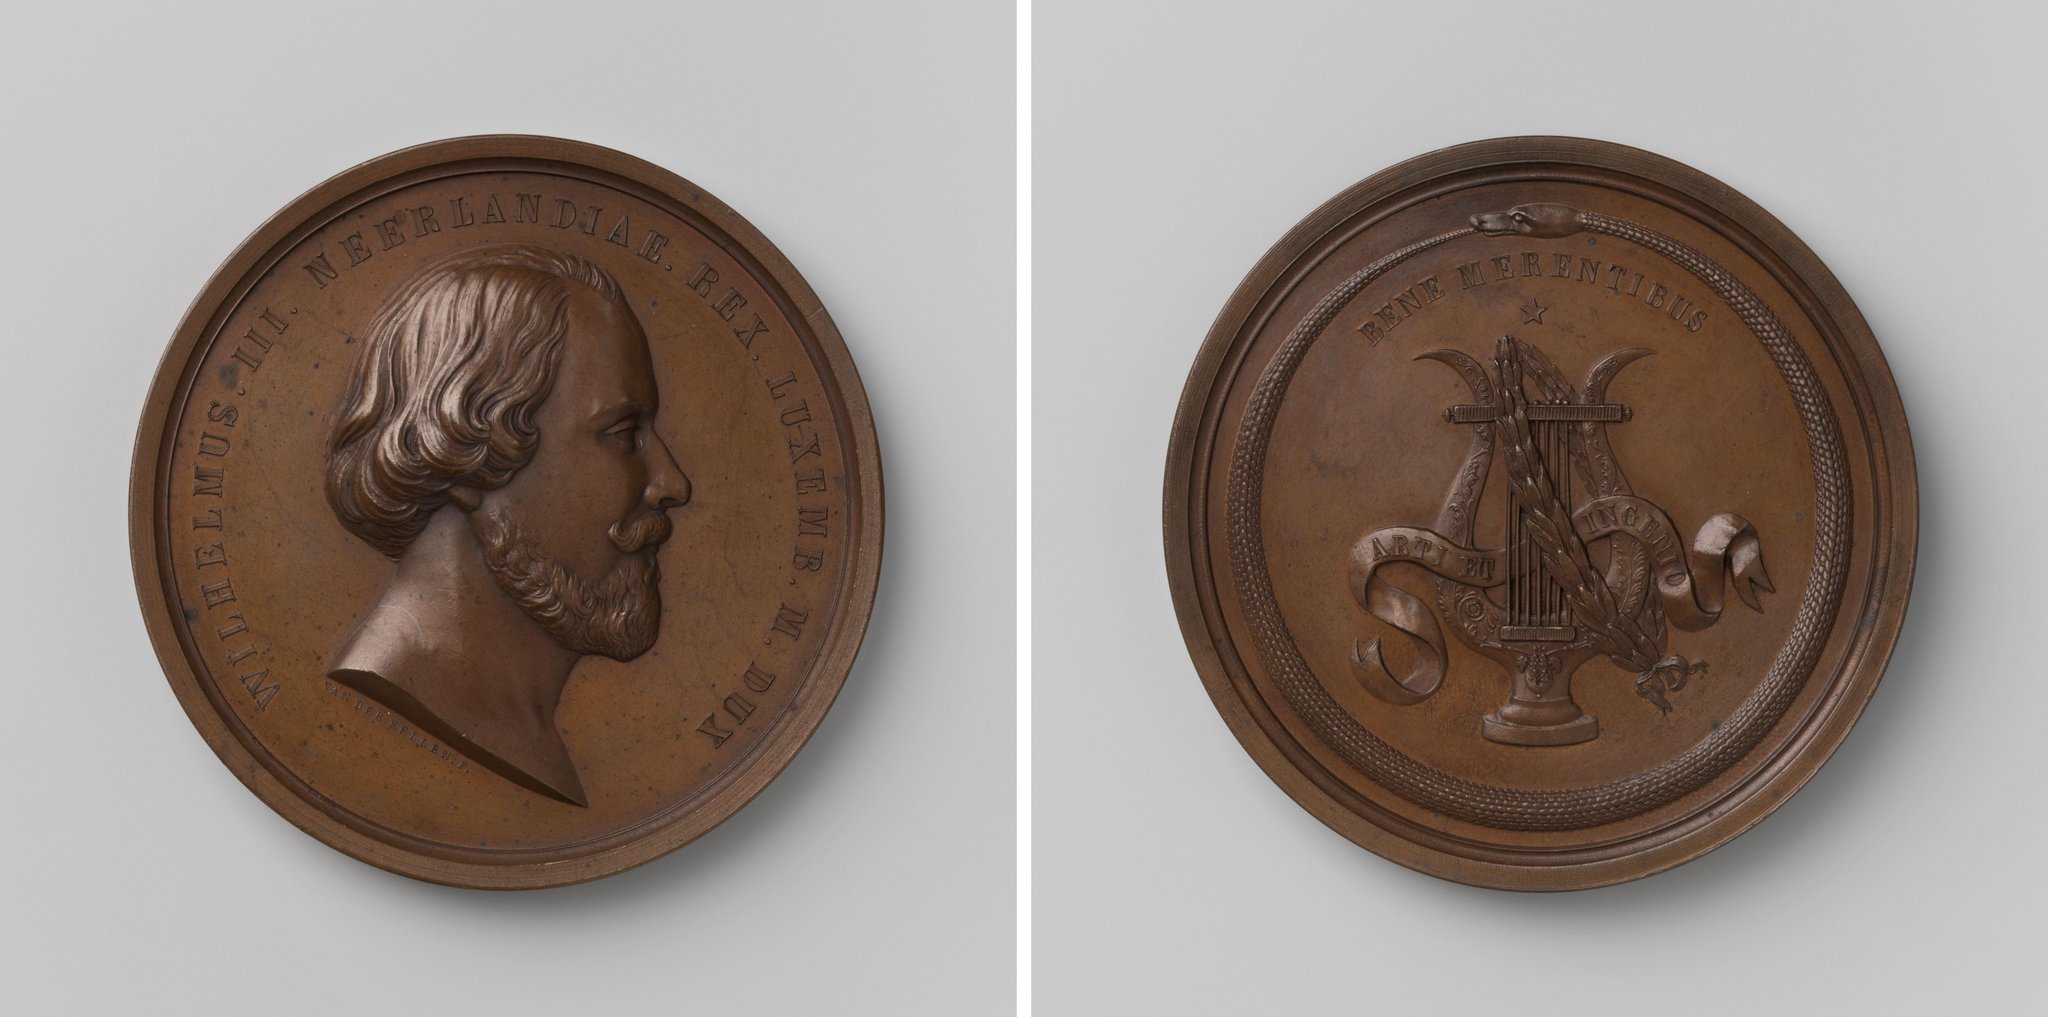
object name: medal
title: Kunstenaars, ter ere van Willem III, koning der Nederlanden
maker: david van der kellen (1804-1879)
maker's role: die cutter, draughtsman, print maker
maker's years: 1804-1879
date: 1849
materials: bronze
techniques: striking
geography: utrecht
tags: brussels, willem iii (koning der nederlanden)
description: Bronzen penning. Voorzijde: borststuk man binnen omschrift. Keerzijde: lier, waar lauwerkrans overheen hangt en wimpel met opschrift doorheen gevlecht is onder ster binnen omschrift en slangerond.